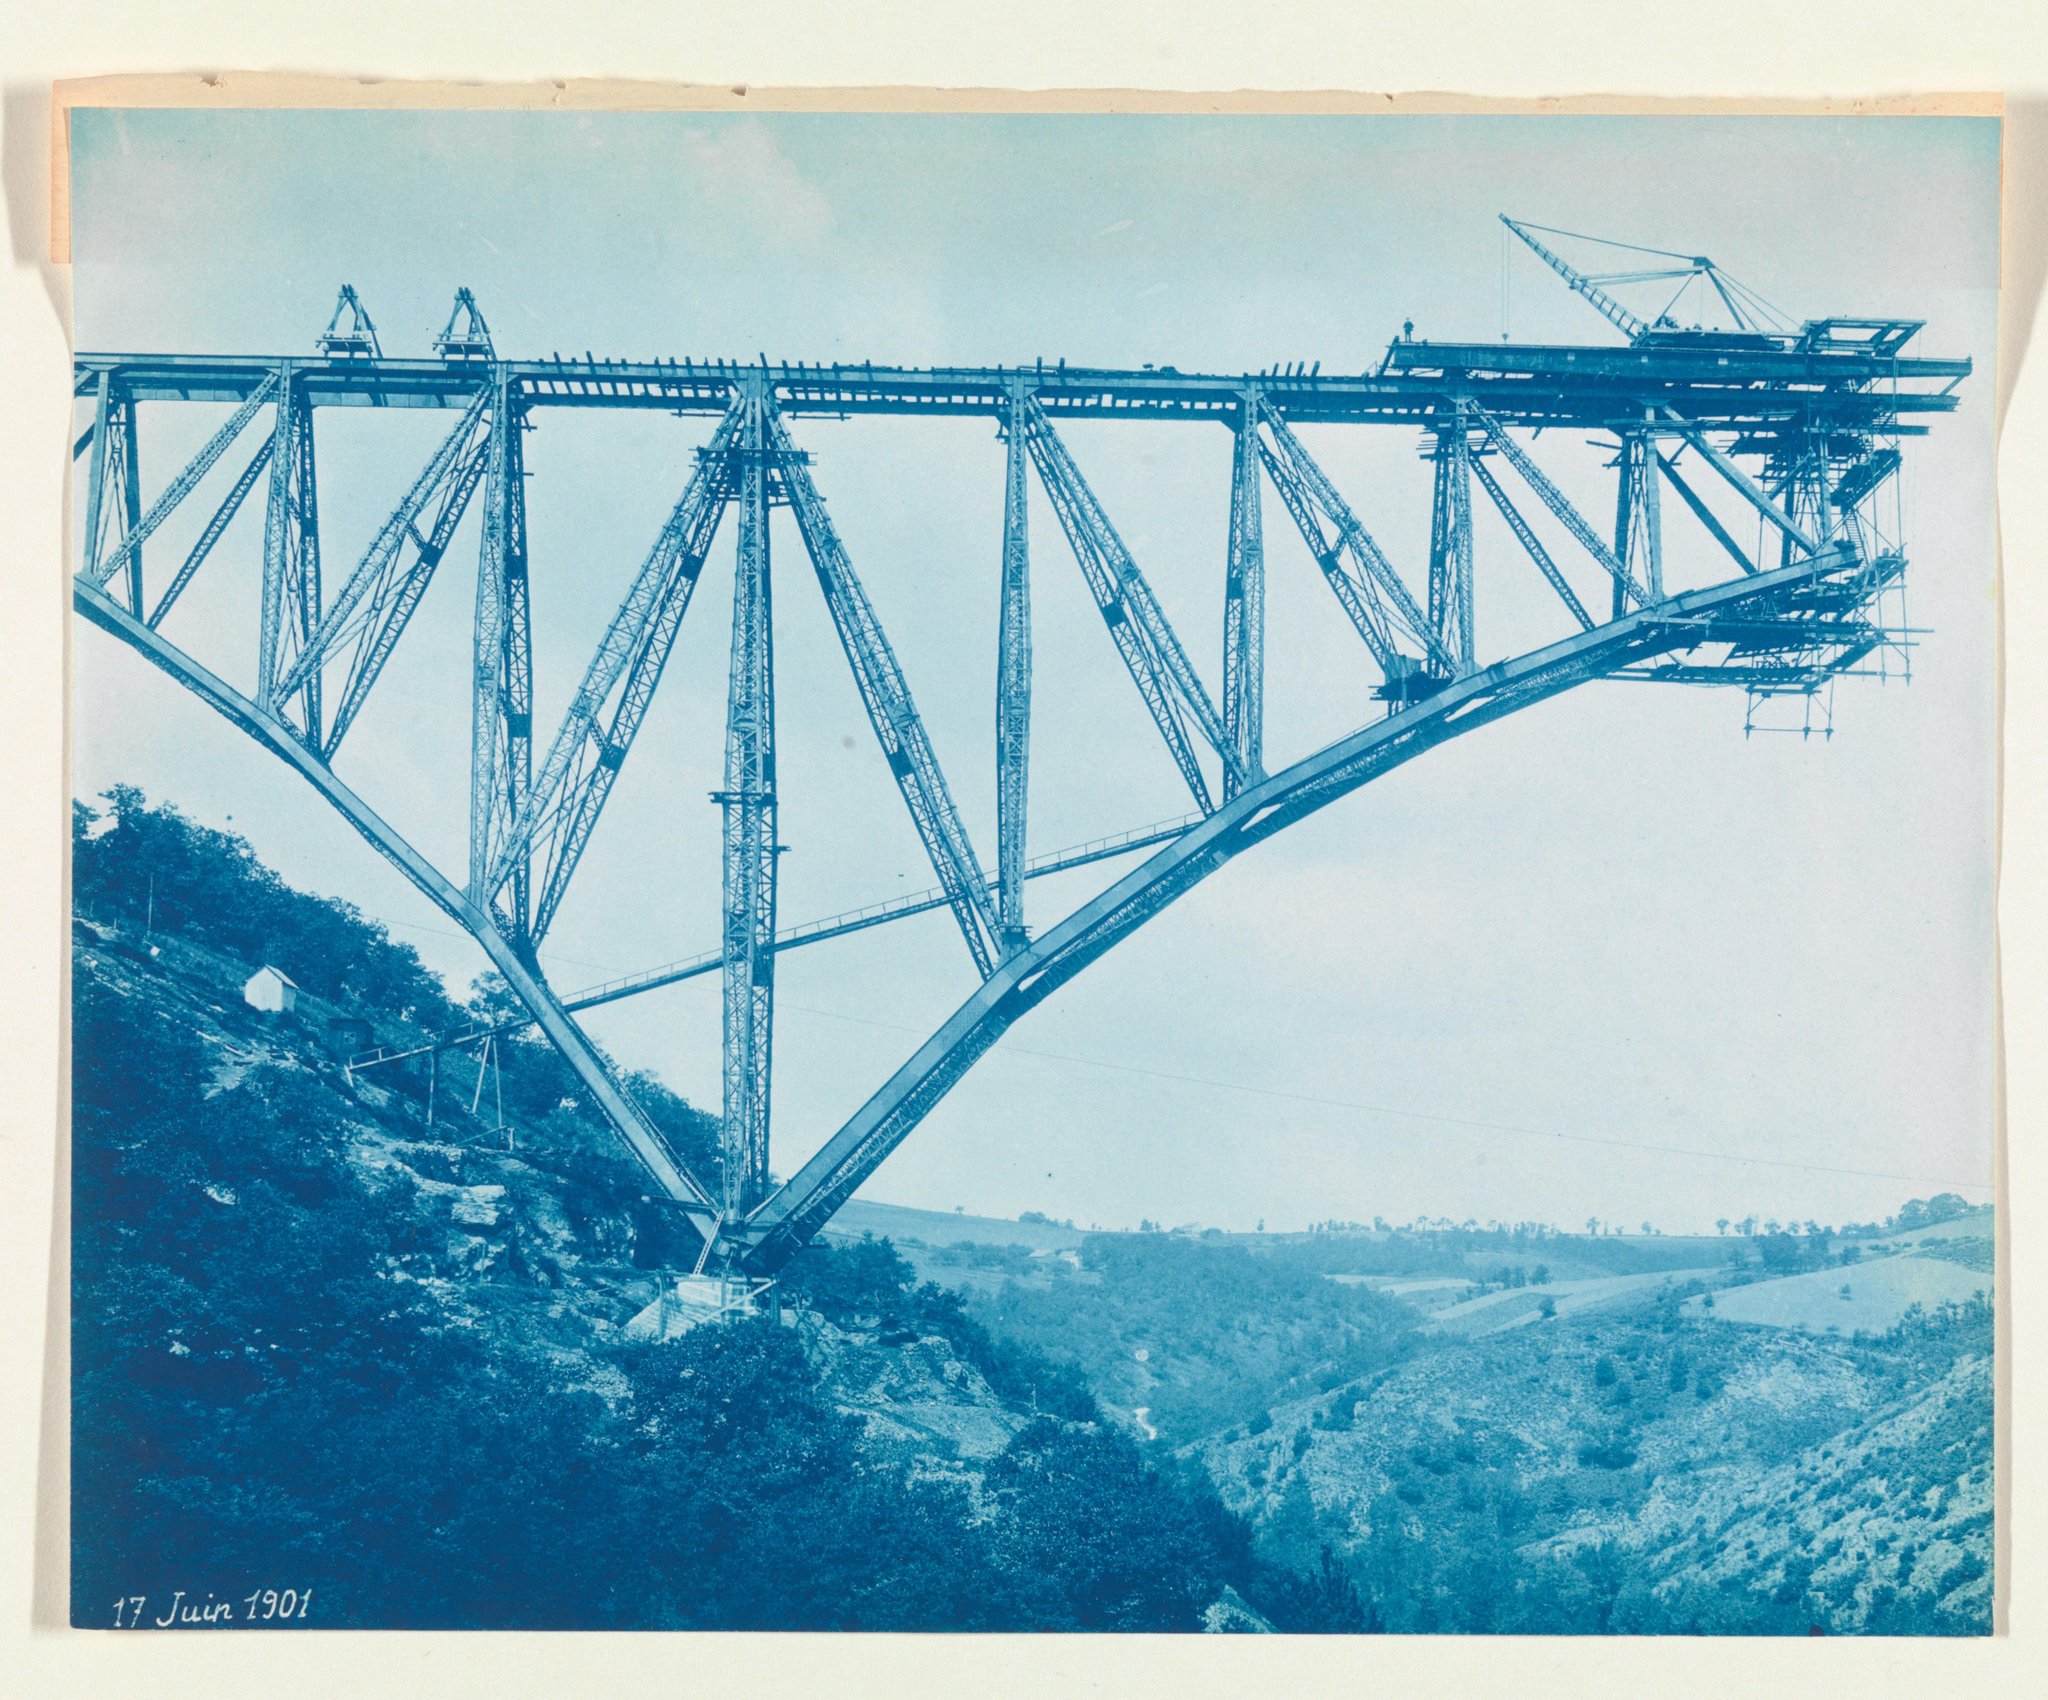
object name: photograph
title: Aanleg van het Viaur Viaduct in Frankrijk door de Societé de Construction des Battignolles, 17 juni 1901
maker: Anonymous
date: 1901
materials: photographic support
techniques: cyanotype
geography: france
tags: viaduct, making the overground structures (~ building activities)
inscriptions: date